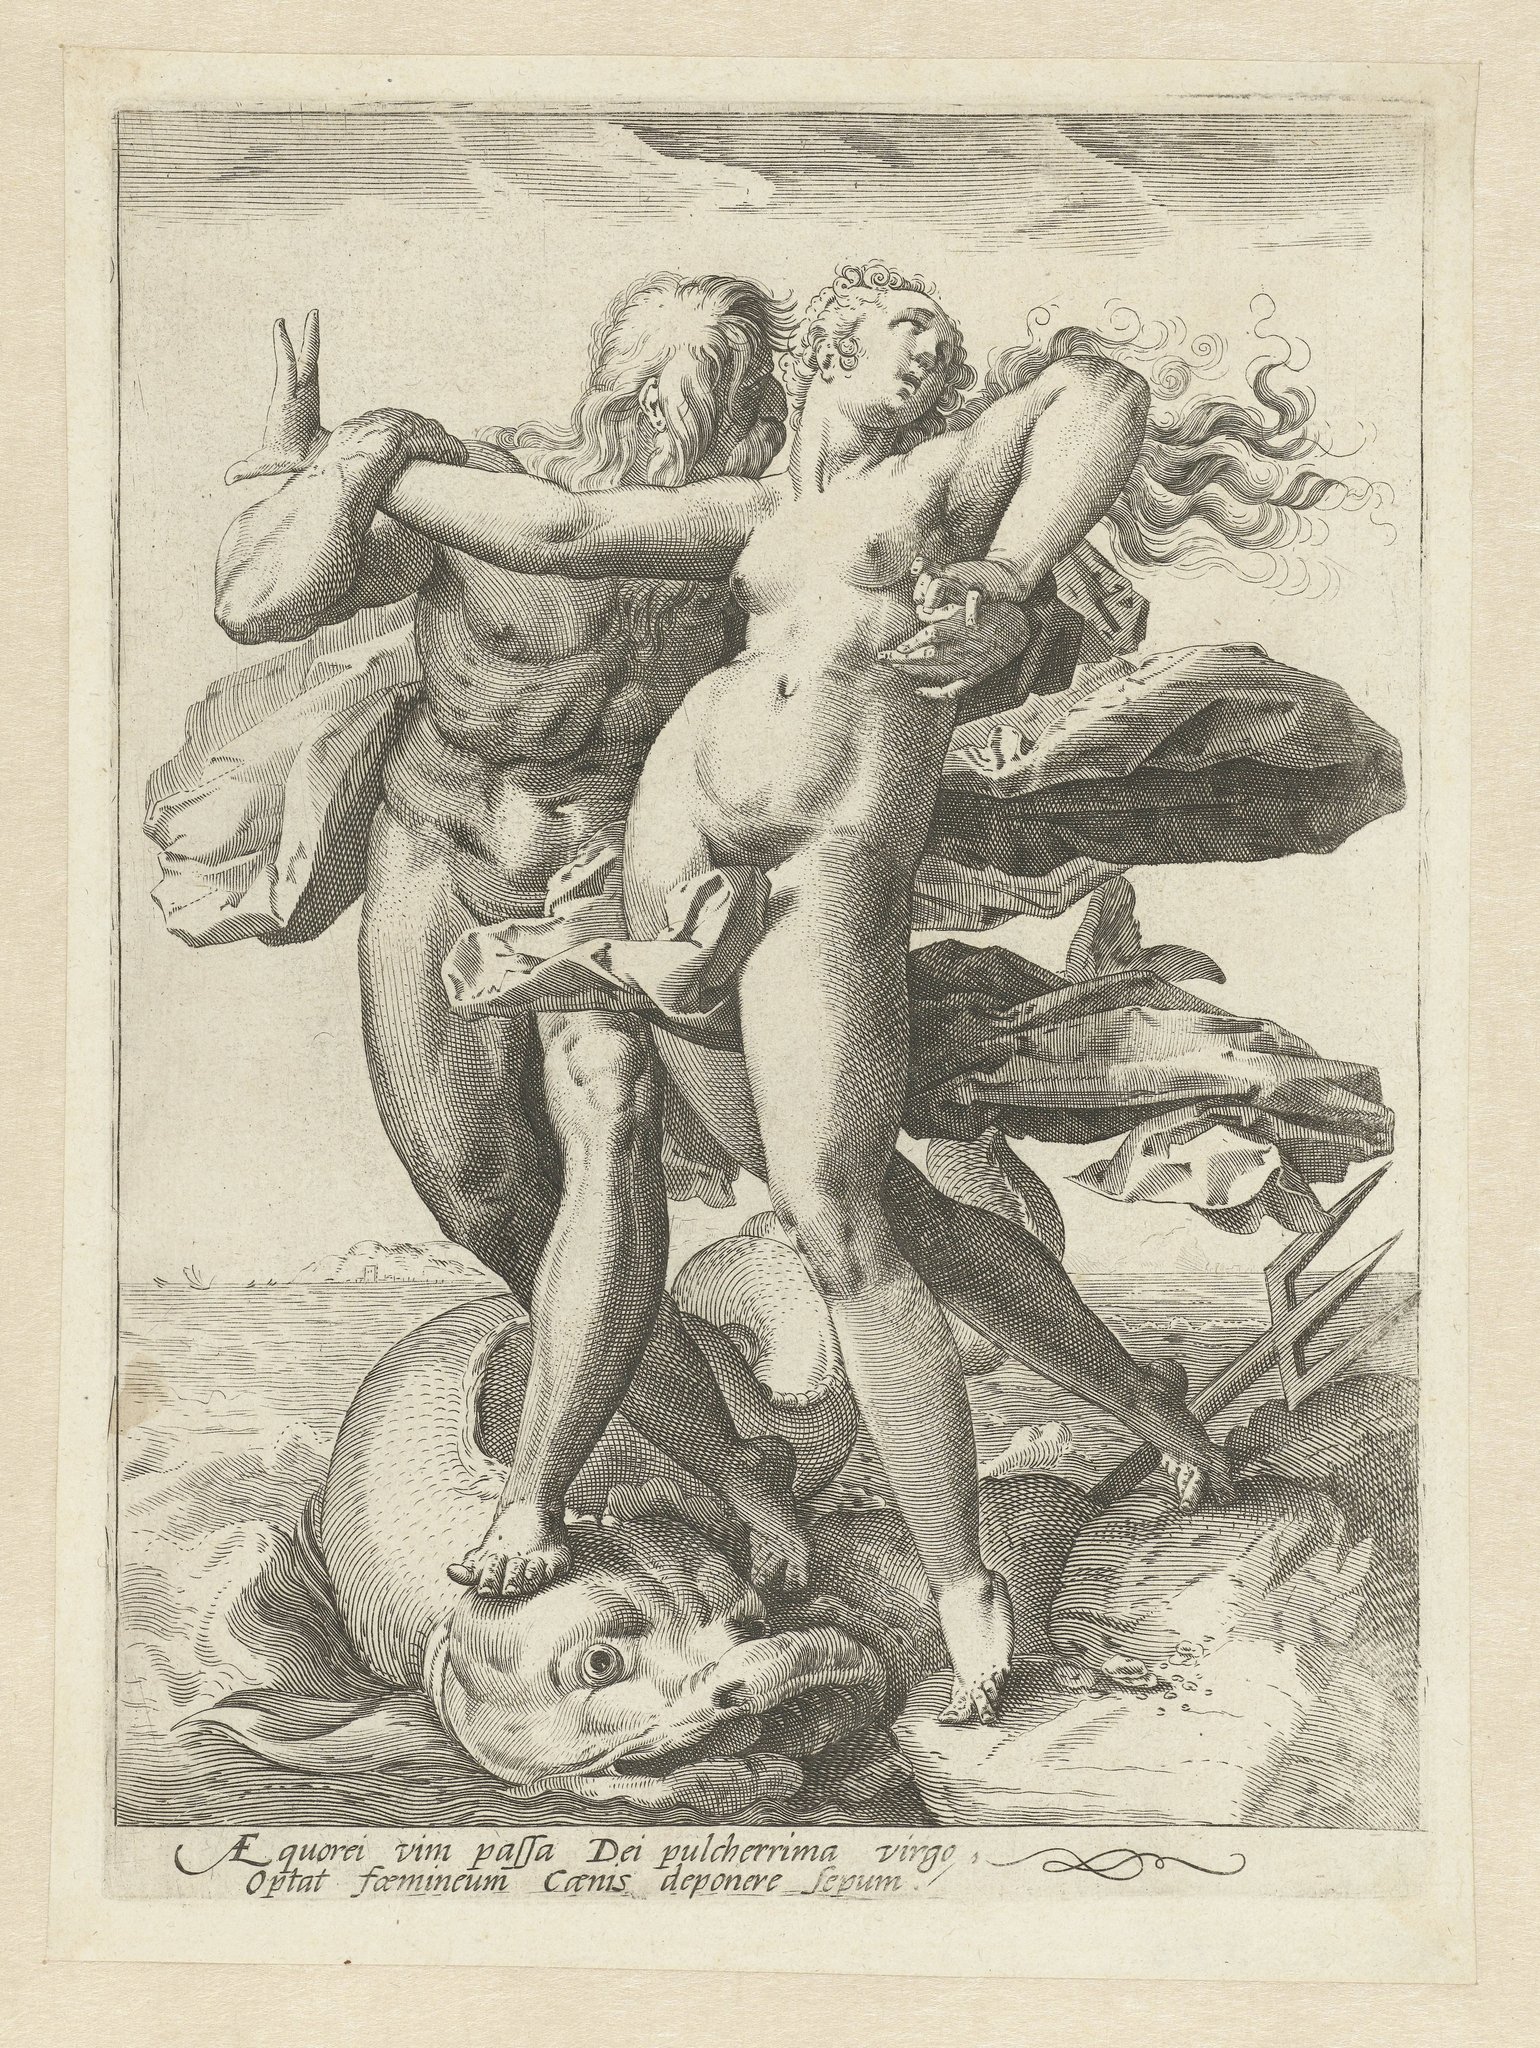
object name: print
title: Neptunus en Caenis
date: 1586-1590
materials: paper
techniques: engraving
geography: haarlem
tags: neptune ravishes caenis, transgender, transsexual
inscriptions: collector's mark: Lugt 1209, collector's mark: Lugt 567, collector's mark: Lugt 2228a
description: Neptunus, staand op een grote vis in zee, grijpt de maagd Caenis bij haar arm en middel terwijl ze langs de kust loopt. Onder de voorstelling twee regels Latijn.